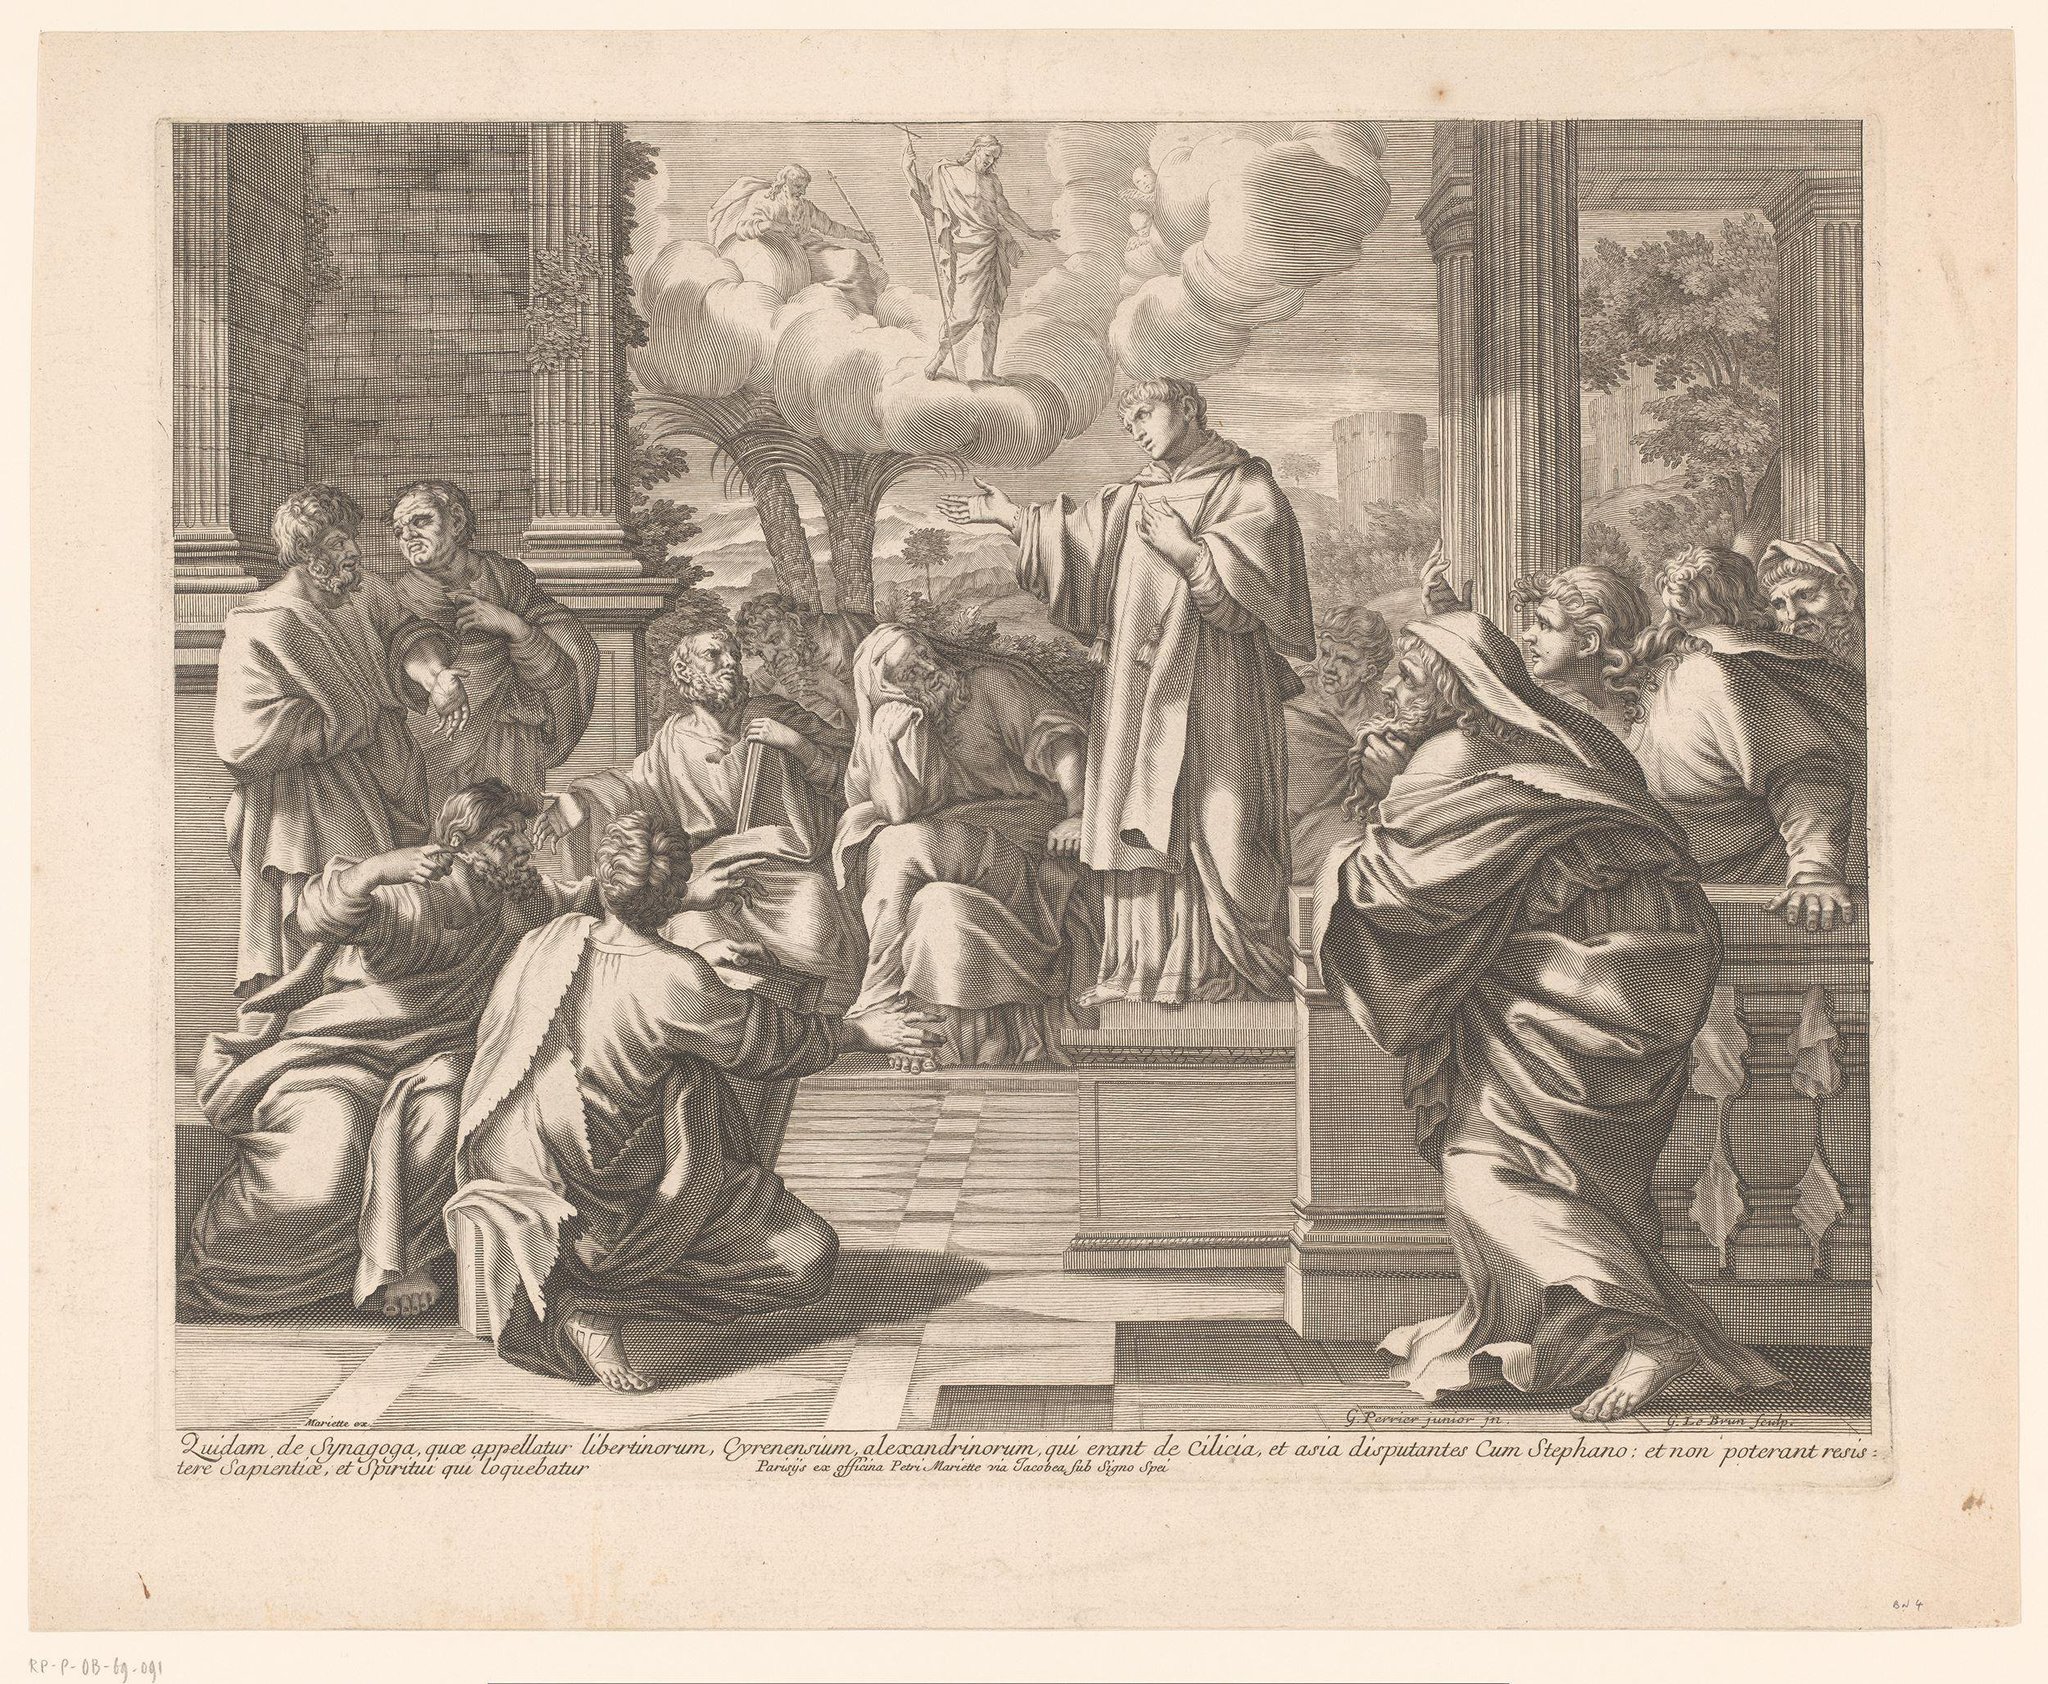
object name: print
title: Predikende H. Stefanus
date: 1635-1660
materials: paper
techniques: engraving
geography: paris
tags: the deacon and (proto)martyr stephen; possible attributes: censer, stones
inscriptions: collector's mark: Lugt 240